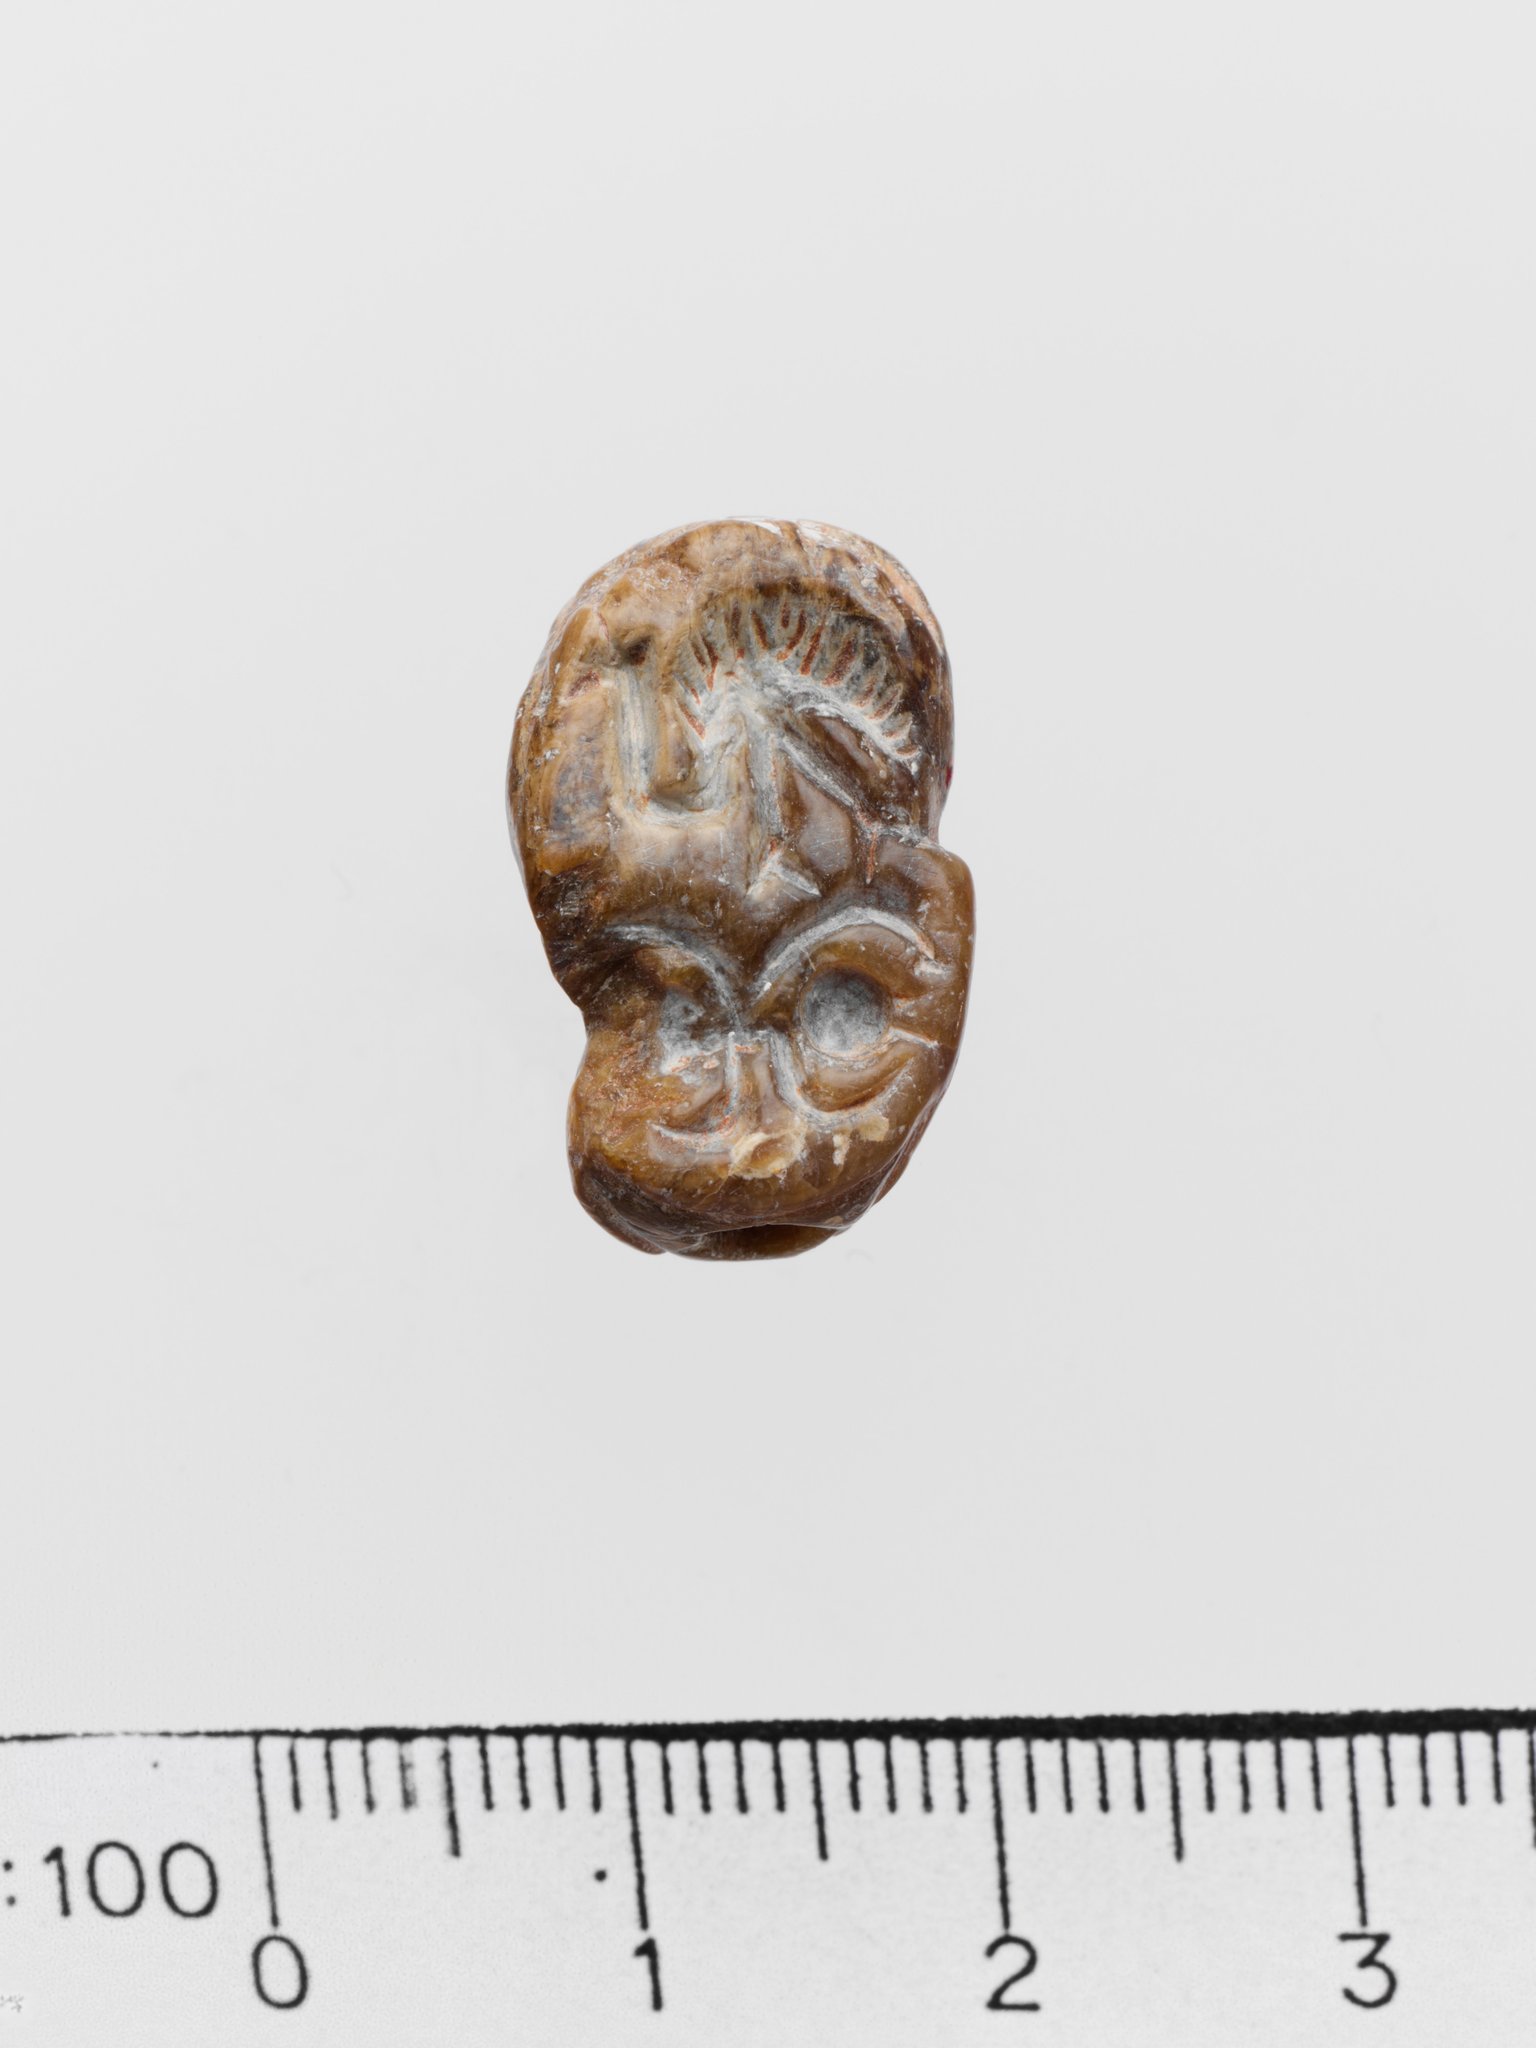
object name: seal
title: Steatite triangular prism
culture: minoan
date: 1900-1750 BCE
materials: stone